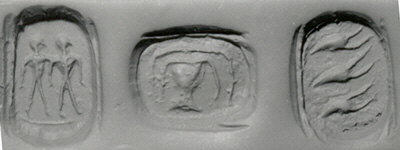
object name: stamp seal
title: Triangular prism with three oval seal faces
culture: minoan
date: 1800-1701 BCE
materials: mineral, stone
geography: crete